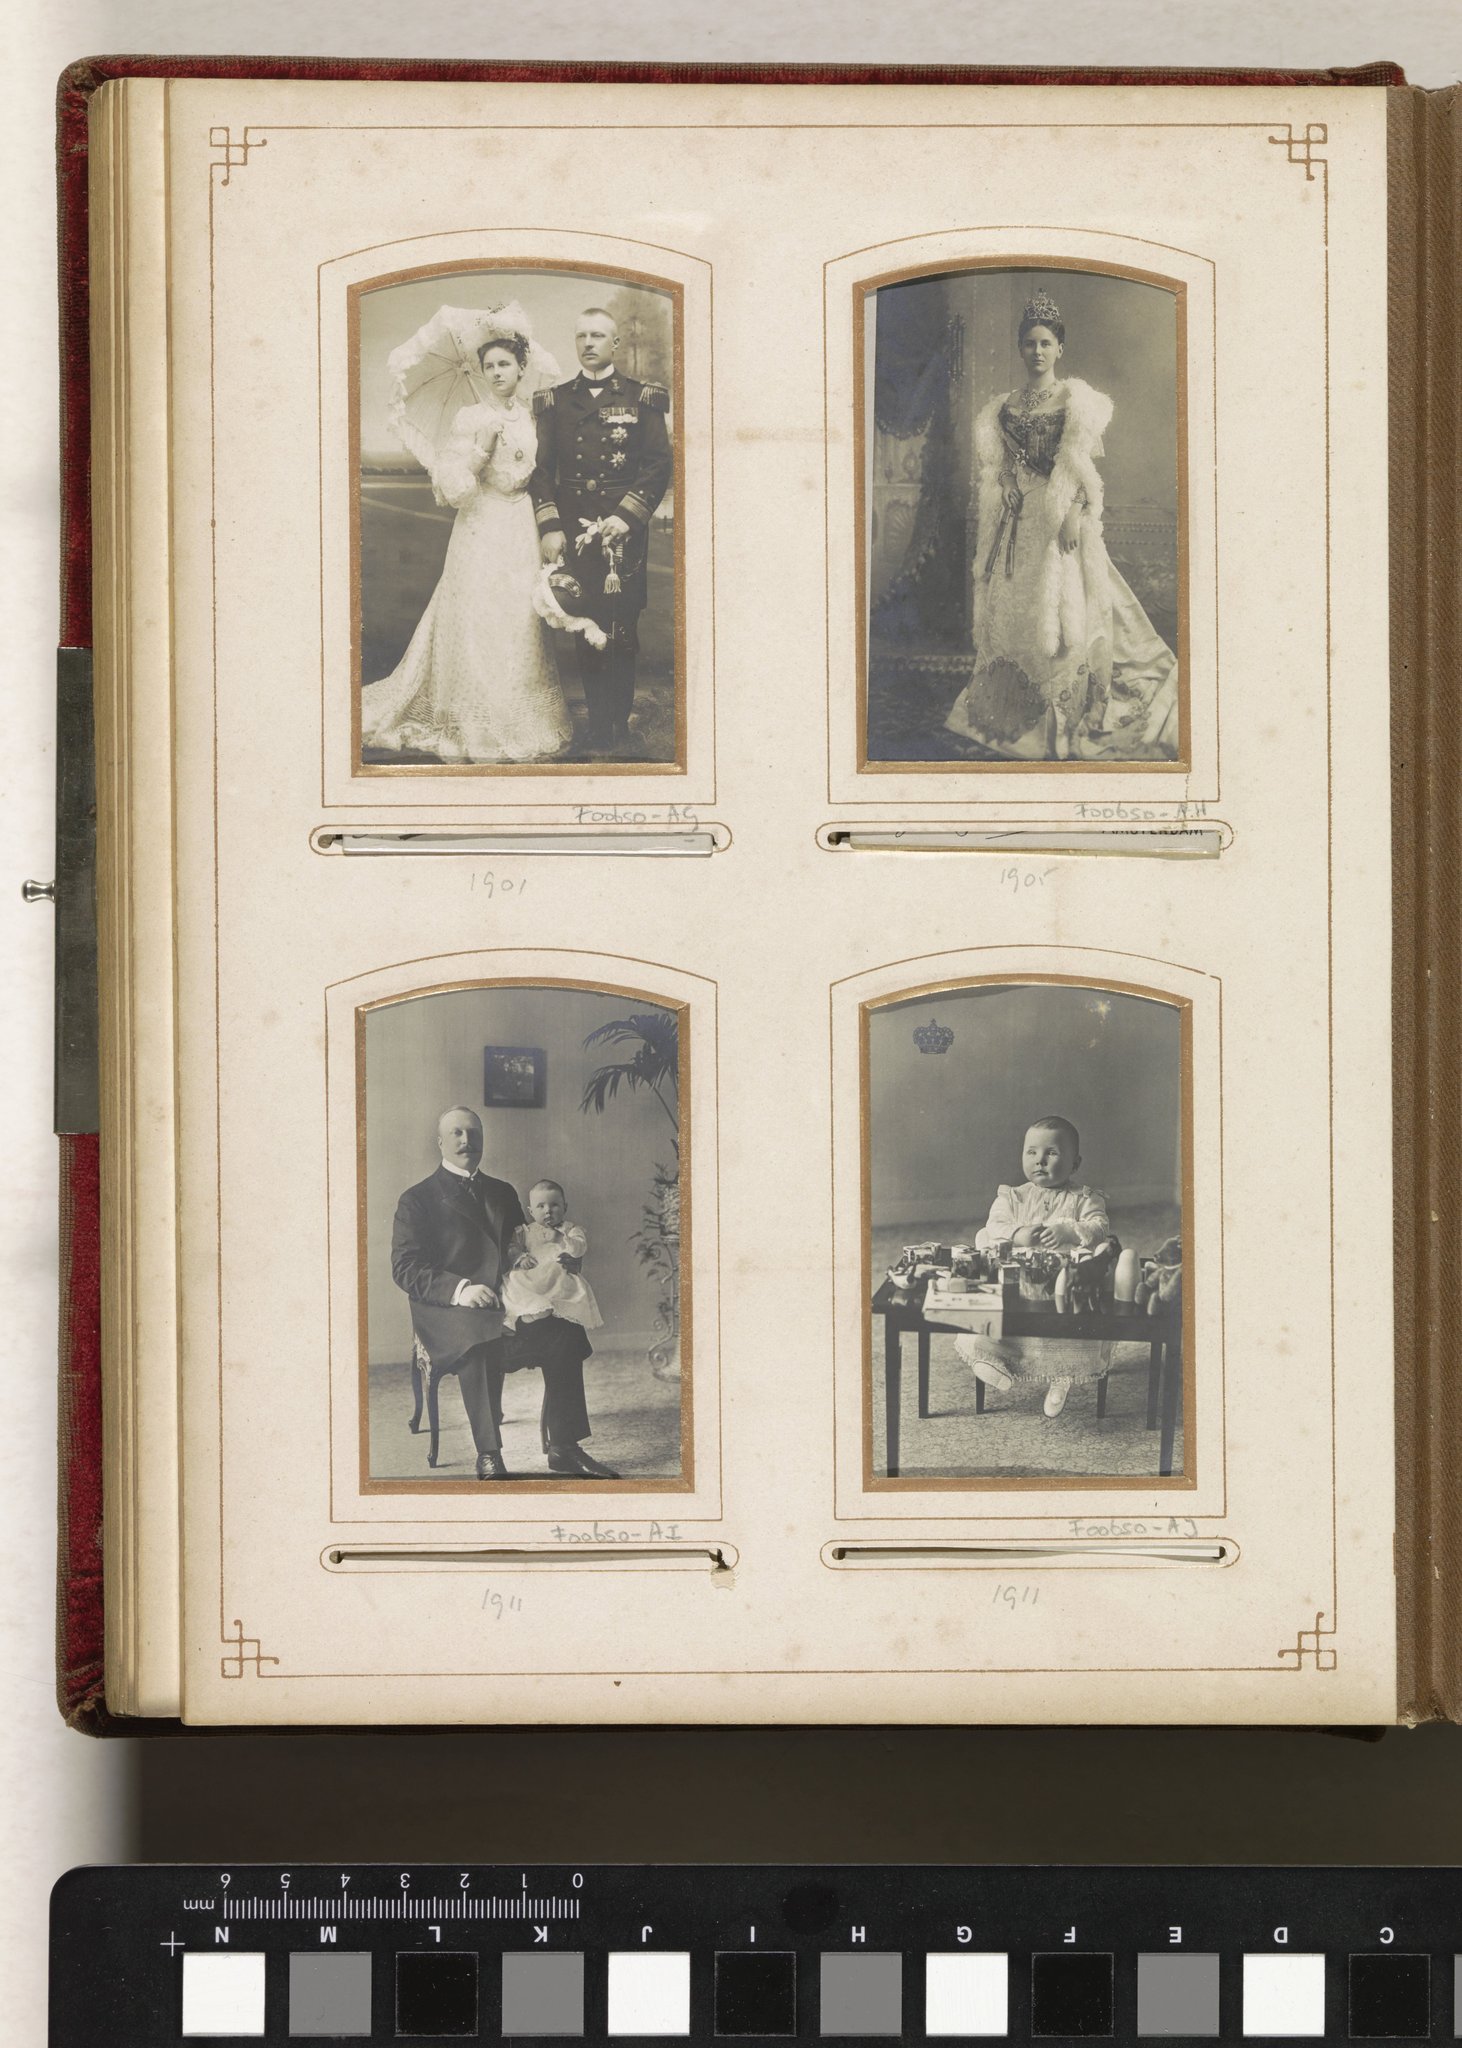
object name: photograph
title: Portret van prins Hendrik met prinses Juliana als peuter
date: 1911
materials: paper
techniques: gelatin silver print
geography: amsterdam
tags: the hague, hendrik (prins der nederlanden (1876-1934)), juliana of the netherlands, father and daughter(s) (family group), prince, historical persons